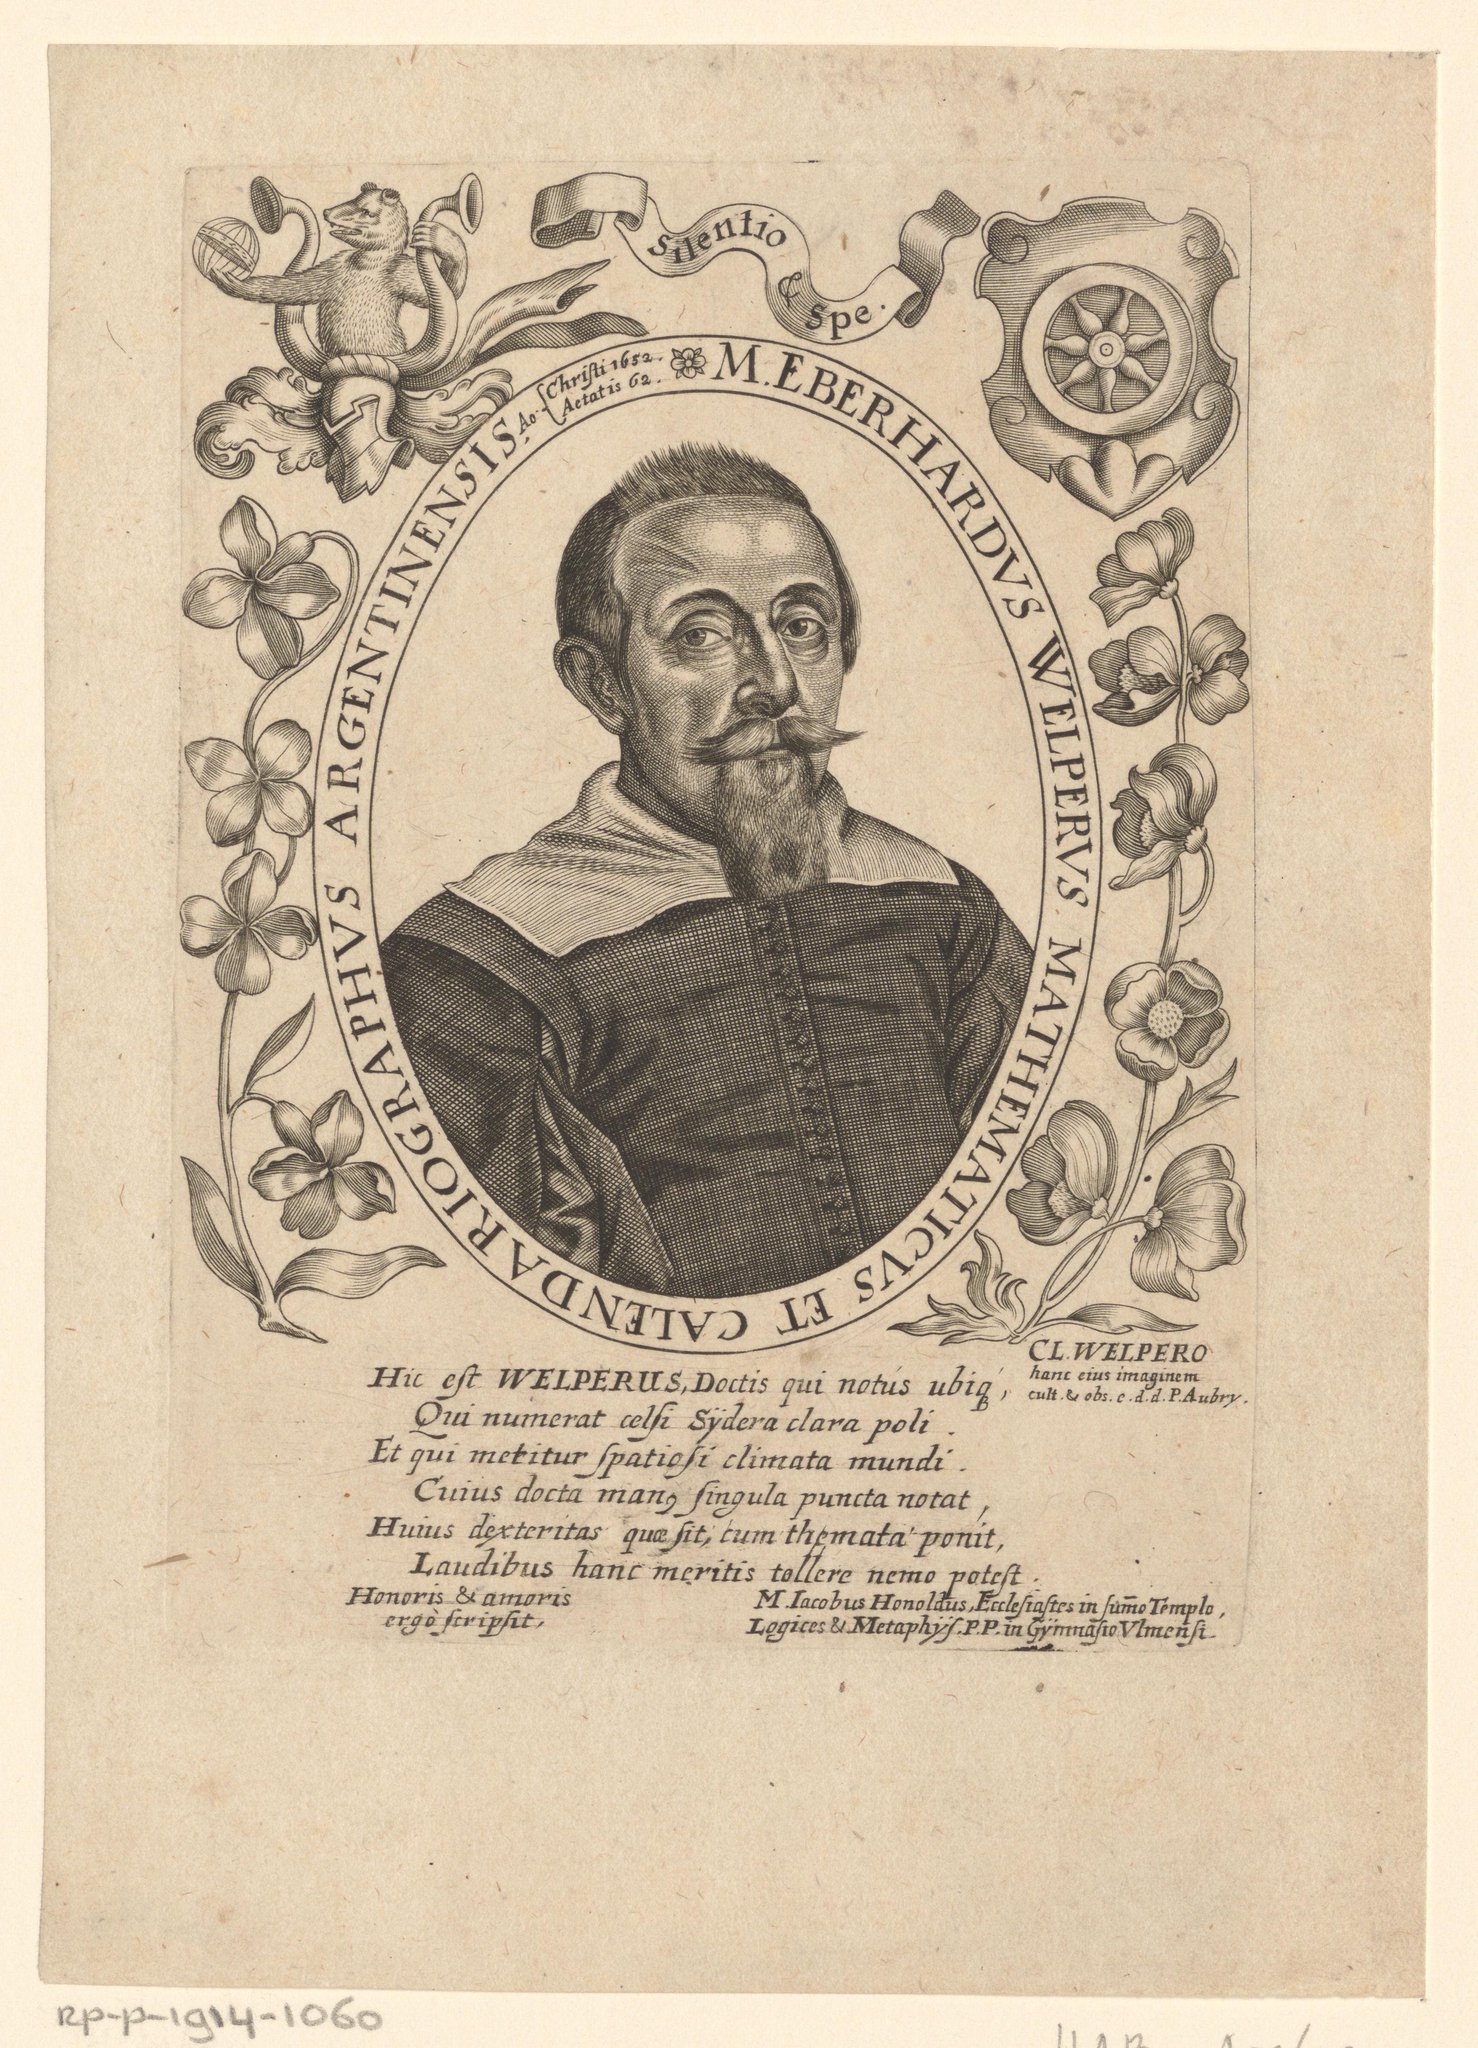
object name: print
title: Portret van Eberhard Welper op 62-jarige leeftijd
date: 1652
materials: paper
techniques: engraving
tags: historical persons, armorial bearing, heraldry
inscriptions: collector's mark: Lugt 2228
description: Met zesregelig onderschrift in het Latijn.